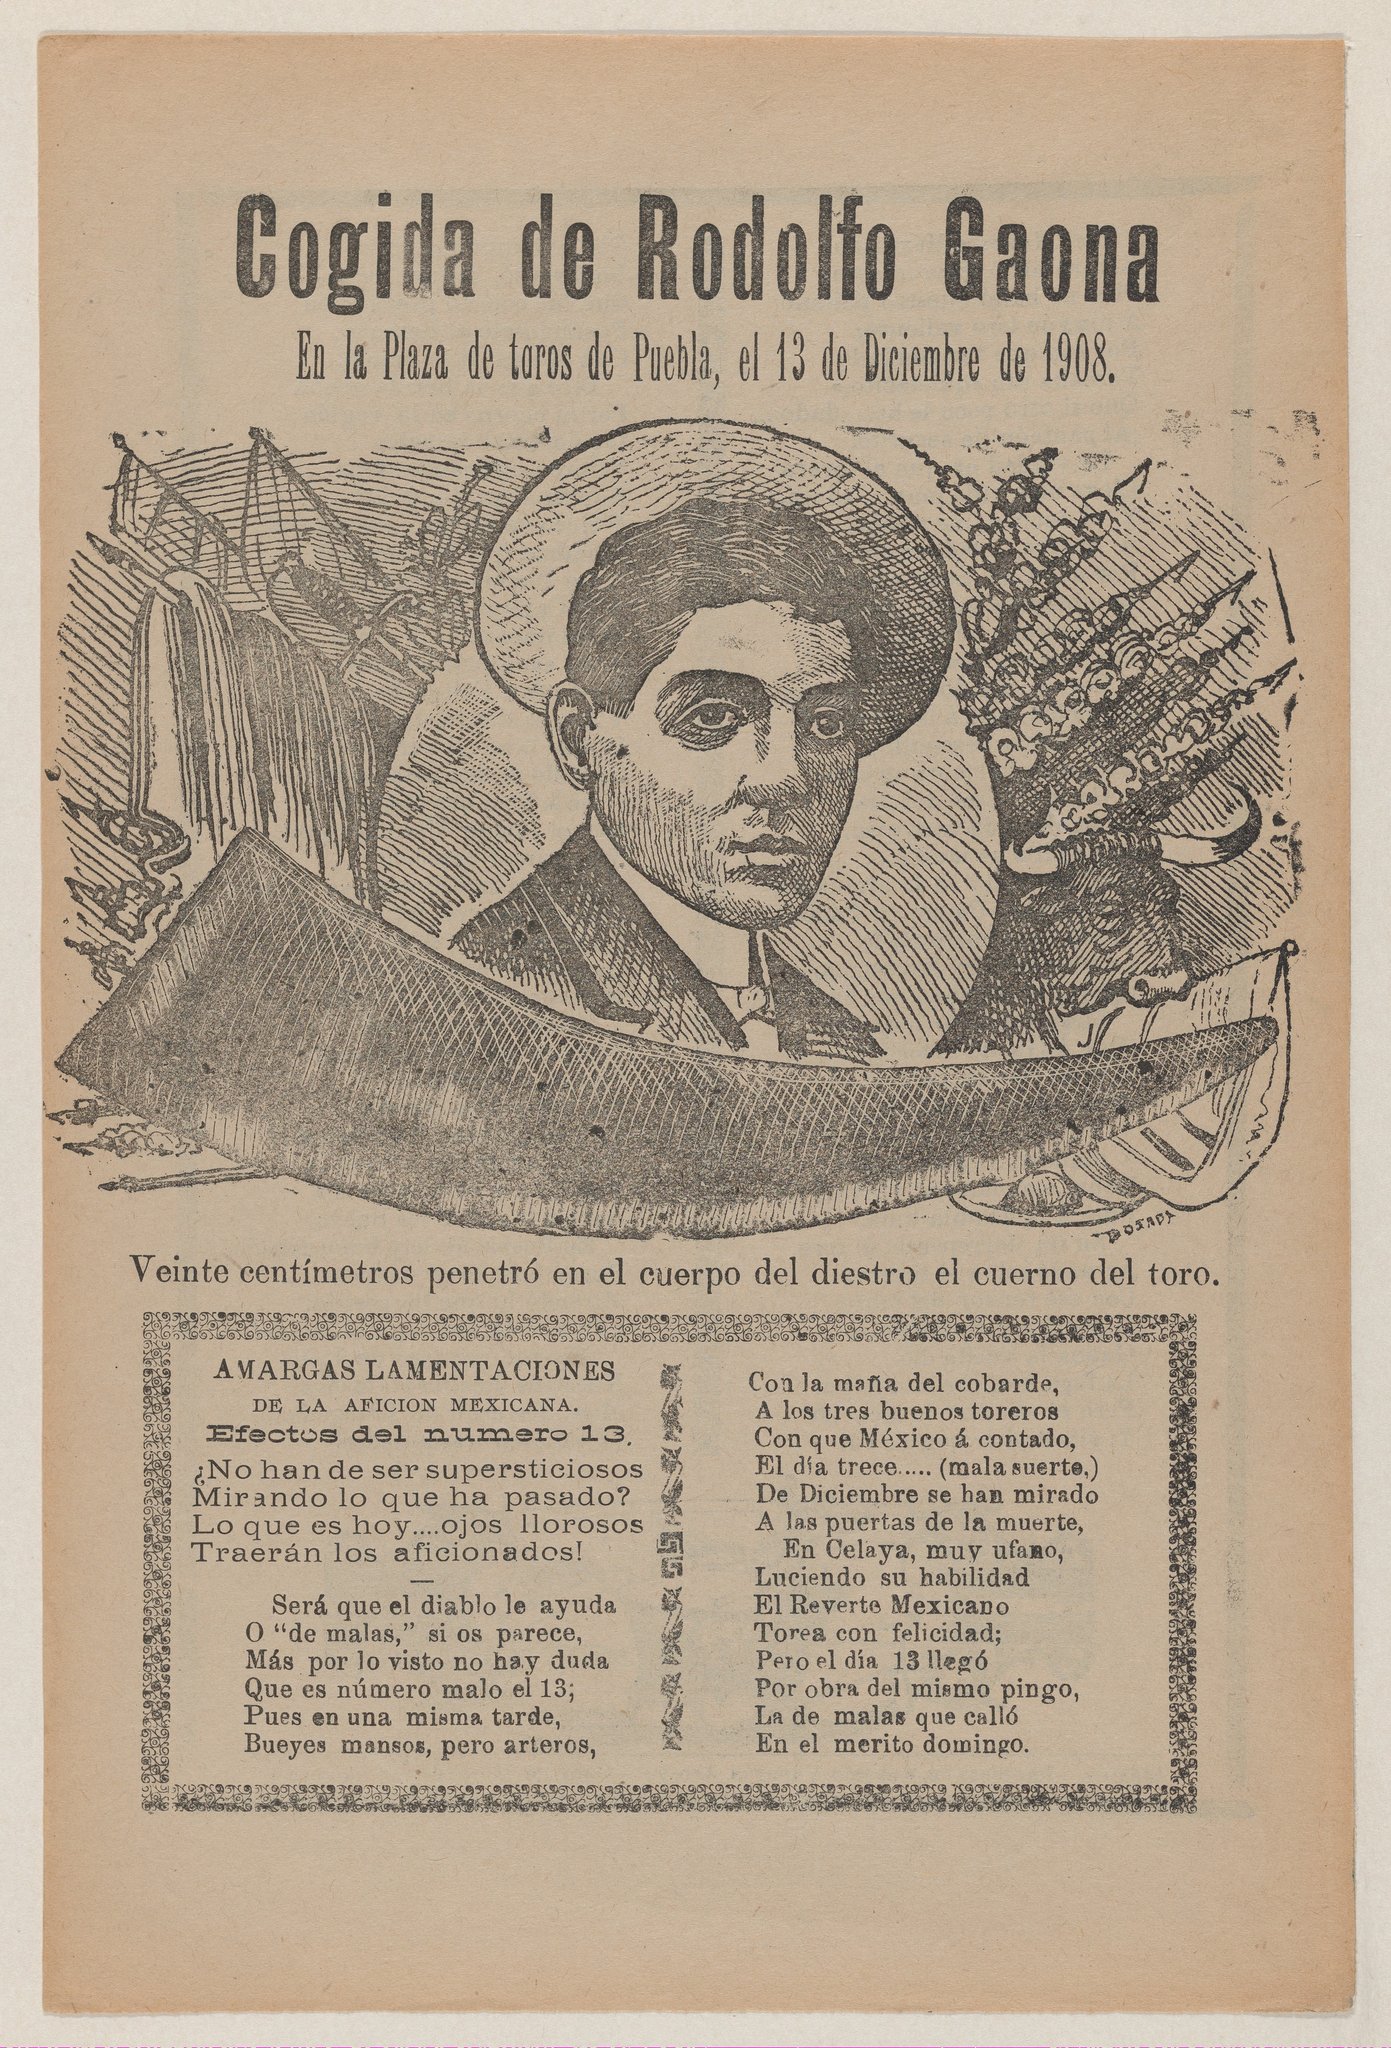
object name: print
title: Broadsheet relating to a bullfight with the famous bullfighter Rodolfo Gaona in the ring at Puebla on 13 December 1908, a description in the bottom section continuing on verso ending with an image of him jumping over a bull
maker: josé guadalupe posada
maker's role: artist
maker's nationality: mexican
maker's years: 1852-1913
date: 1908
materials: paper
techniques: letterpress, lithography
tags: men